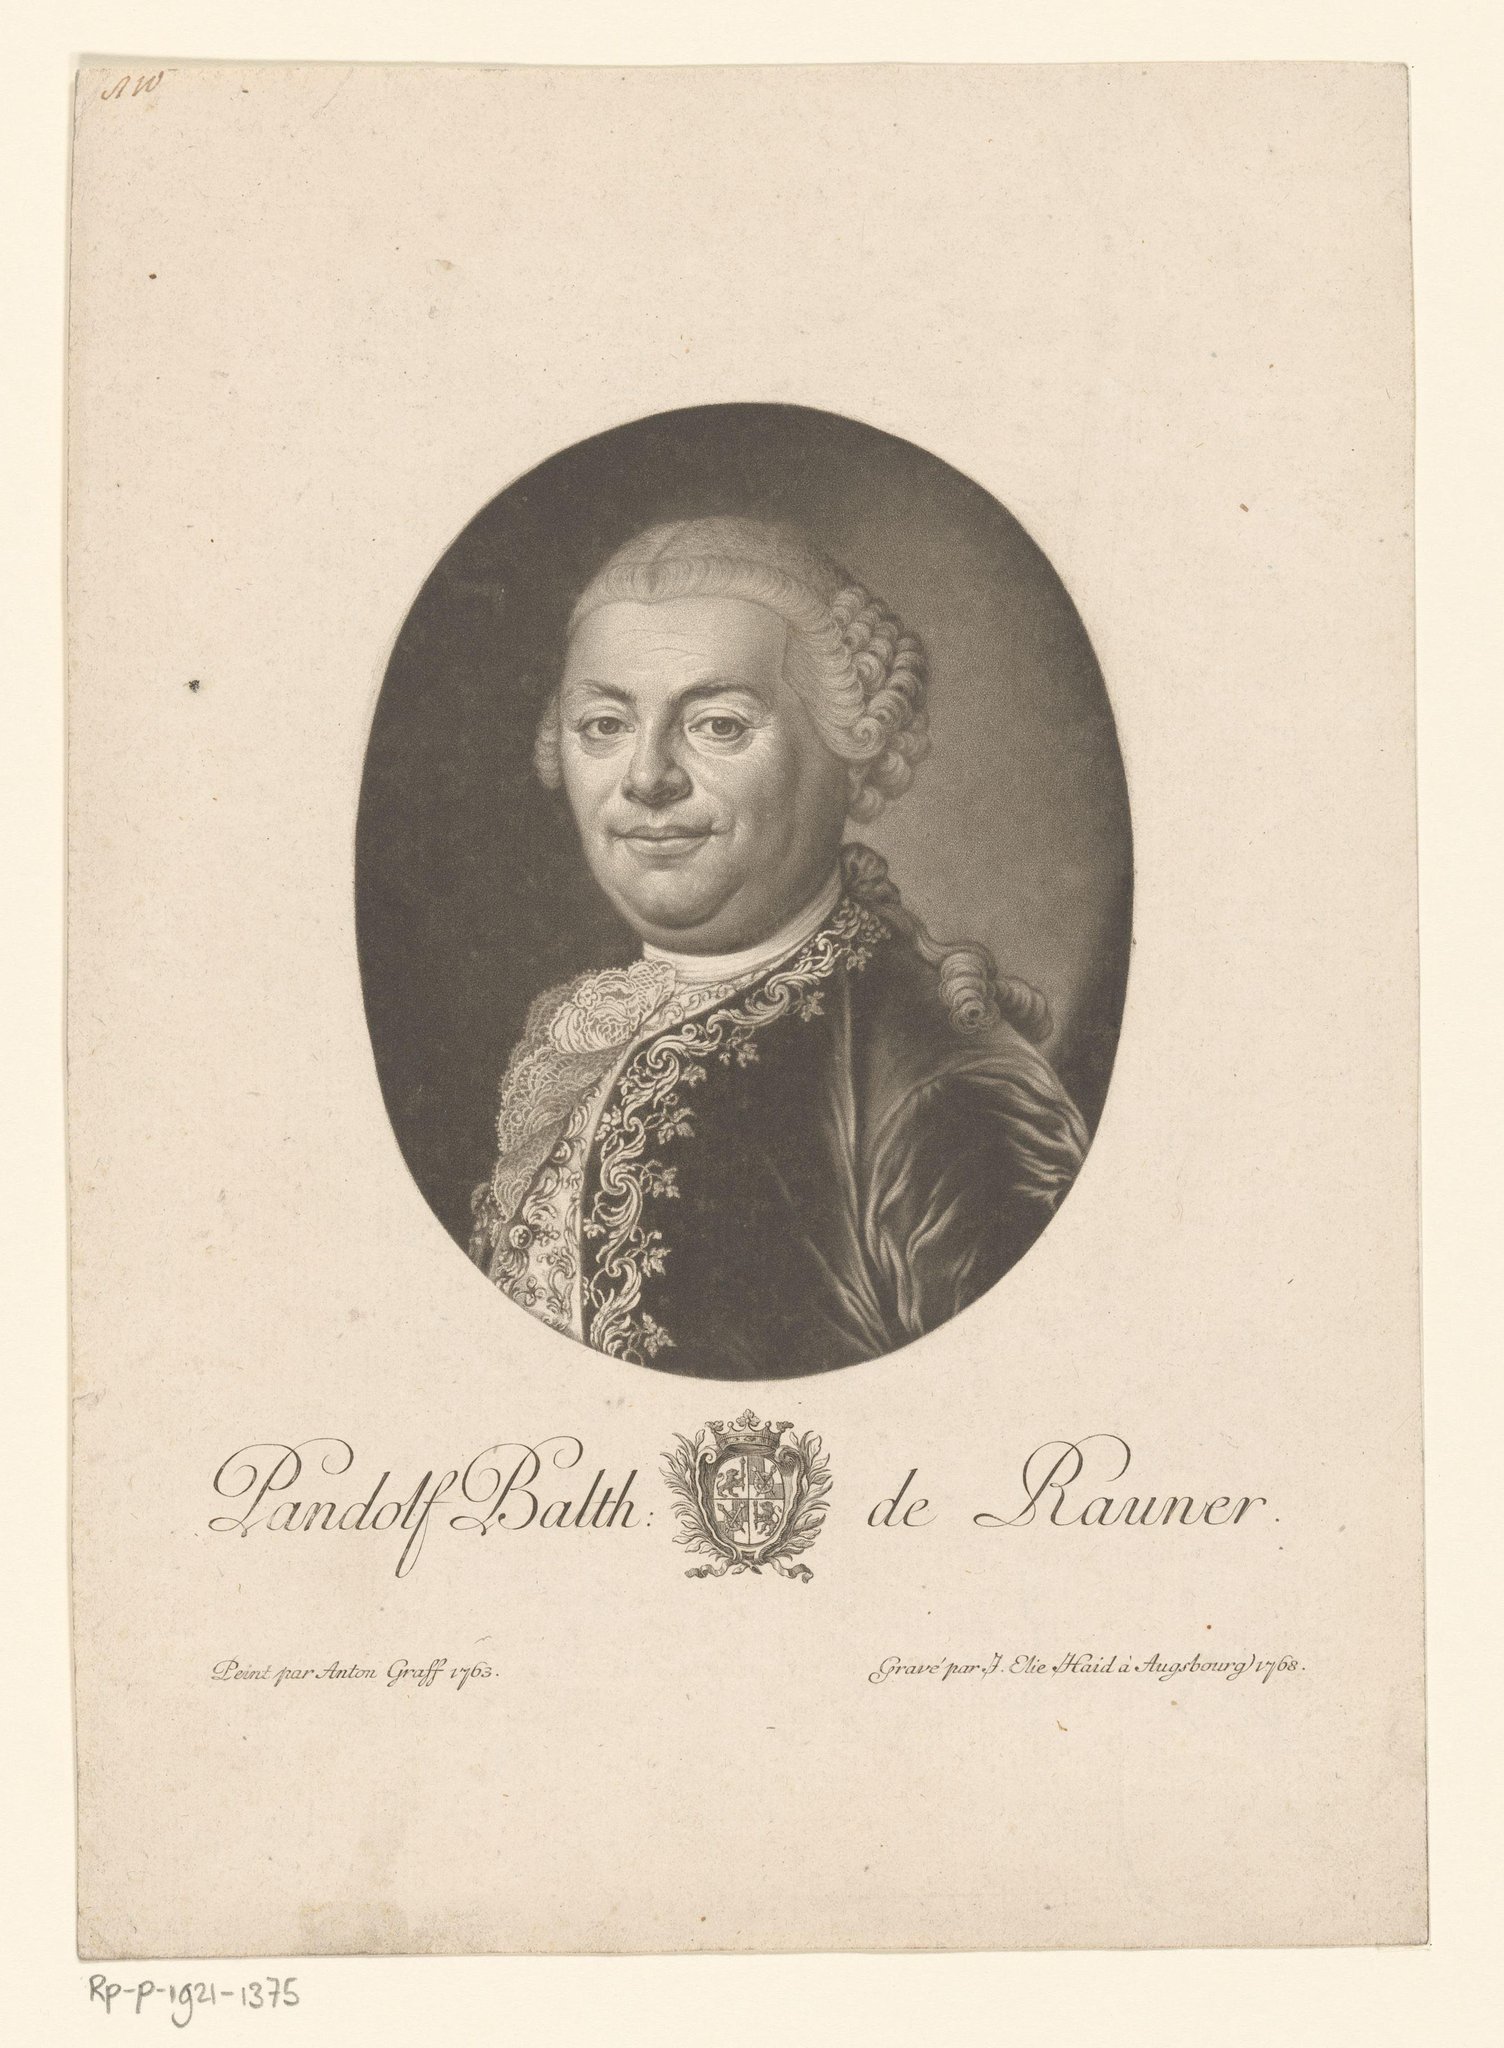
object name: print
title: Portret van Pandolf Balthasar von Rauner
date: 1763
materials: paper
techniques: etching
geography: augsburg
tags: historical persons, armorial bearing, heraldry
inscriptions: collector's mark: Lugt 2233